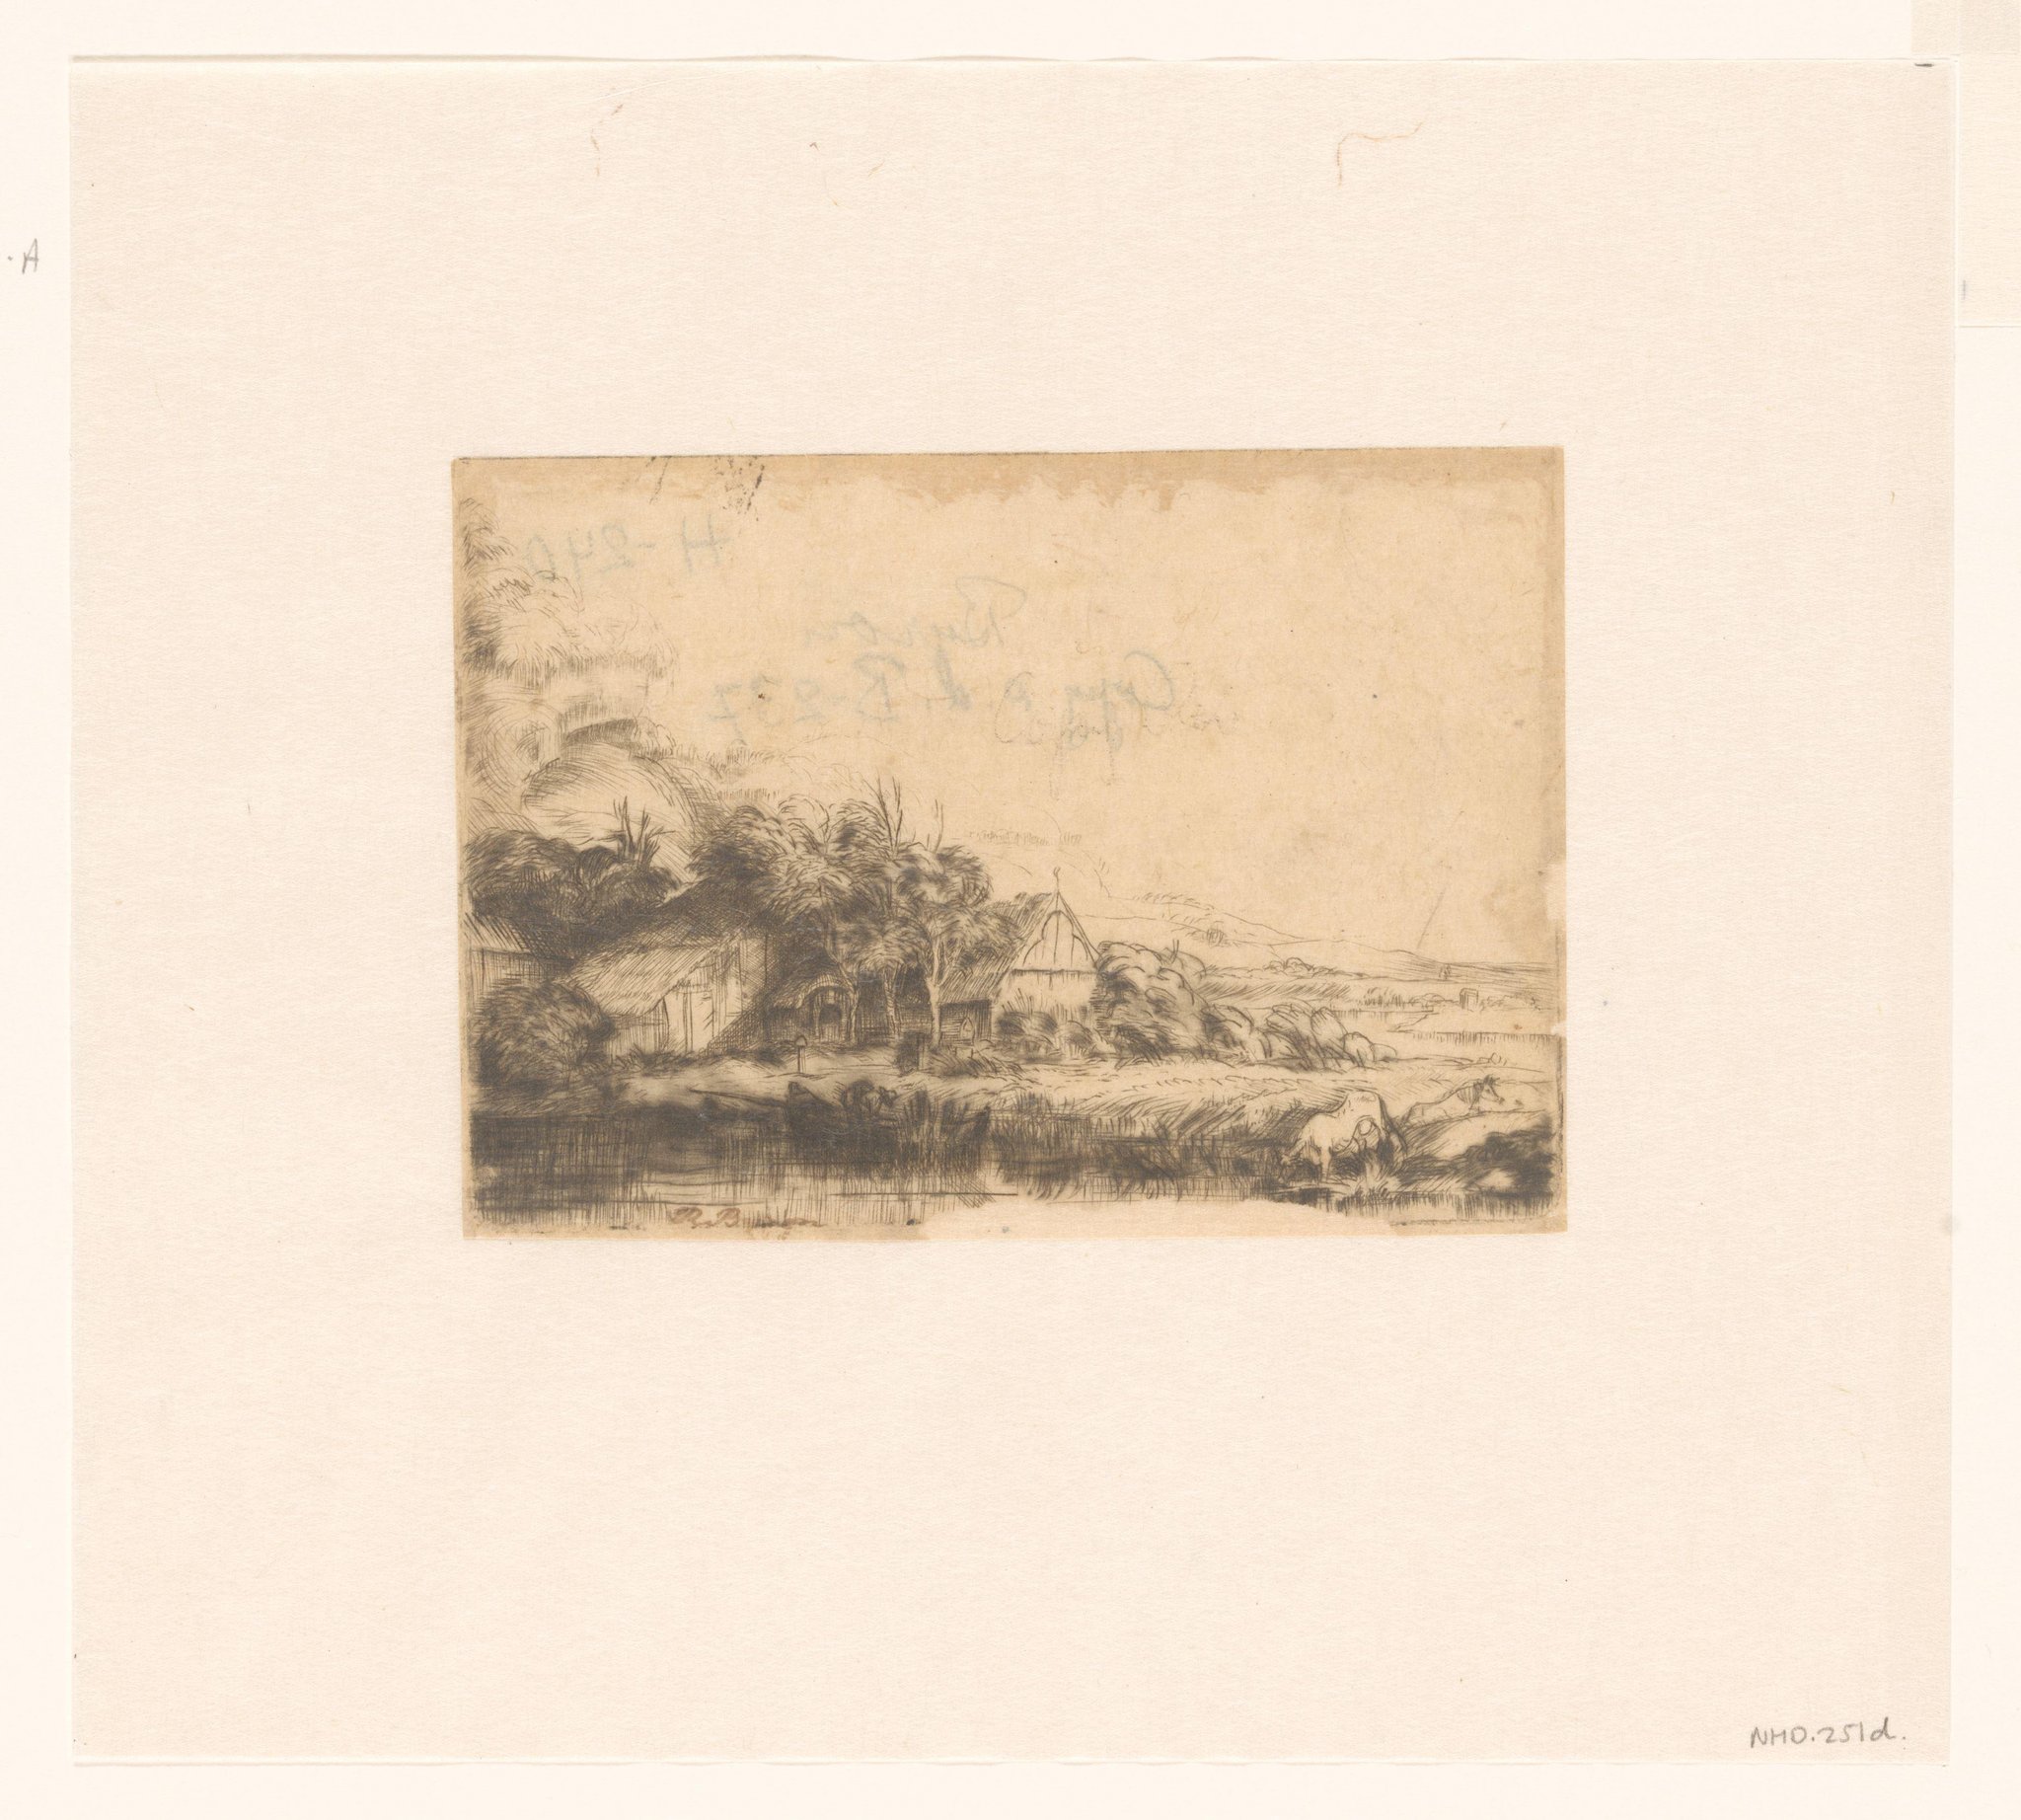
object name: print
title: Landscape with a cow drinking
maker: john smith of chichester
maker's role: print maker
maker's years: 1717-1764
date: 1750-1799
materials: paper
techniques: drypoint, etching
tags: cow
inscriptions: collector's mark: Lugt 2228, collector's mark: Lugt 2760